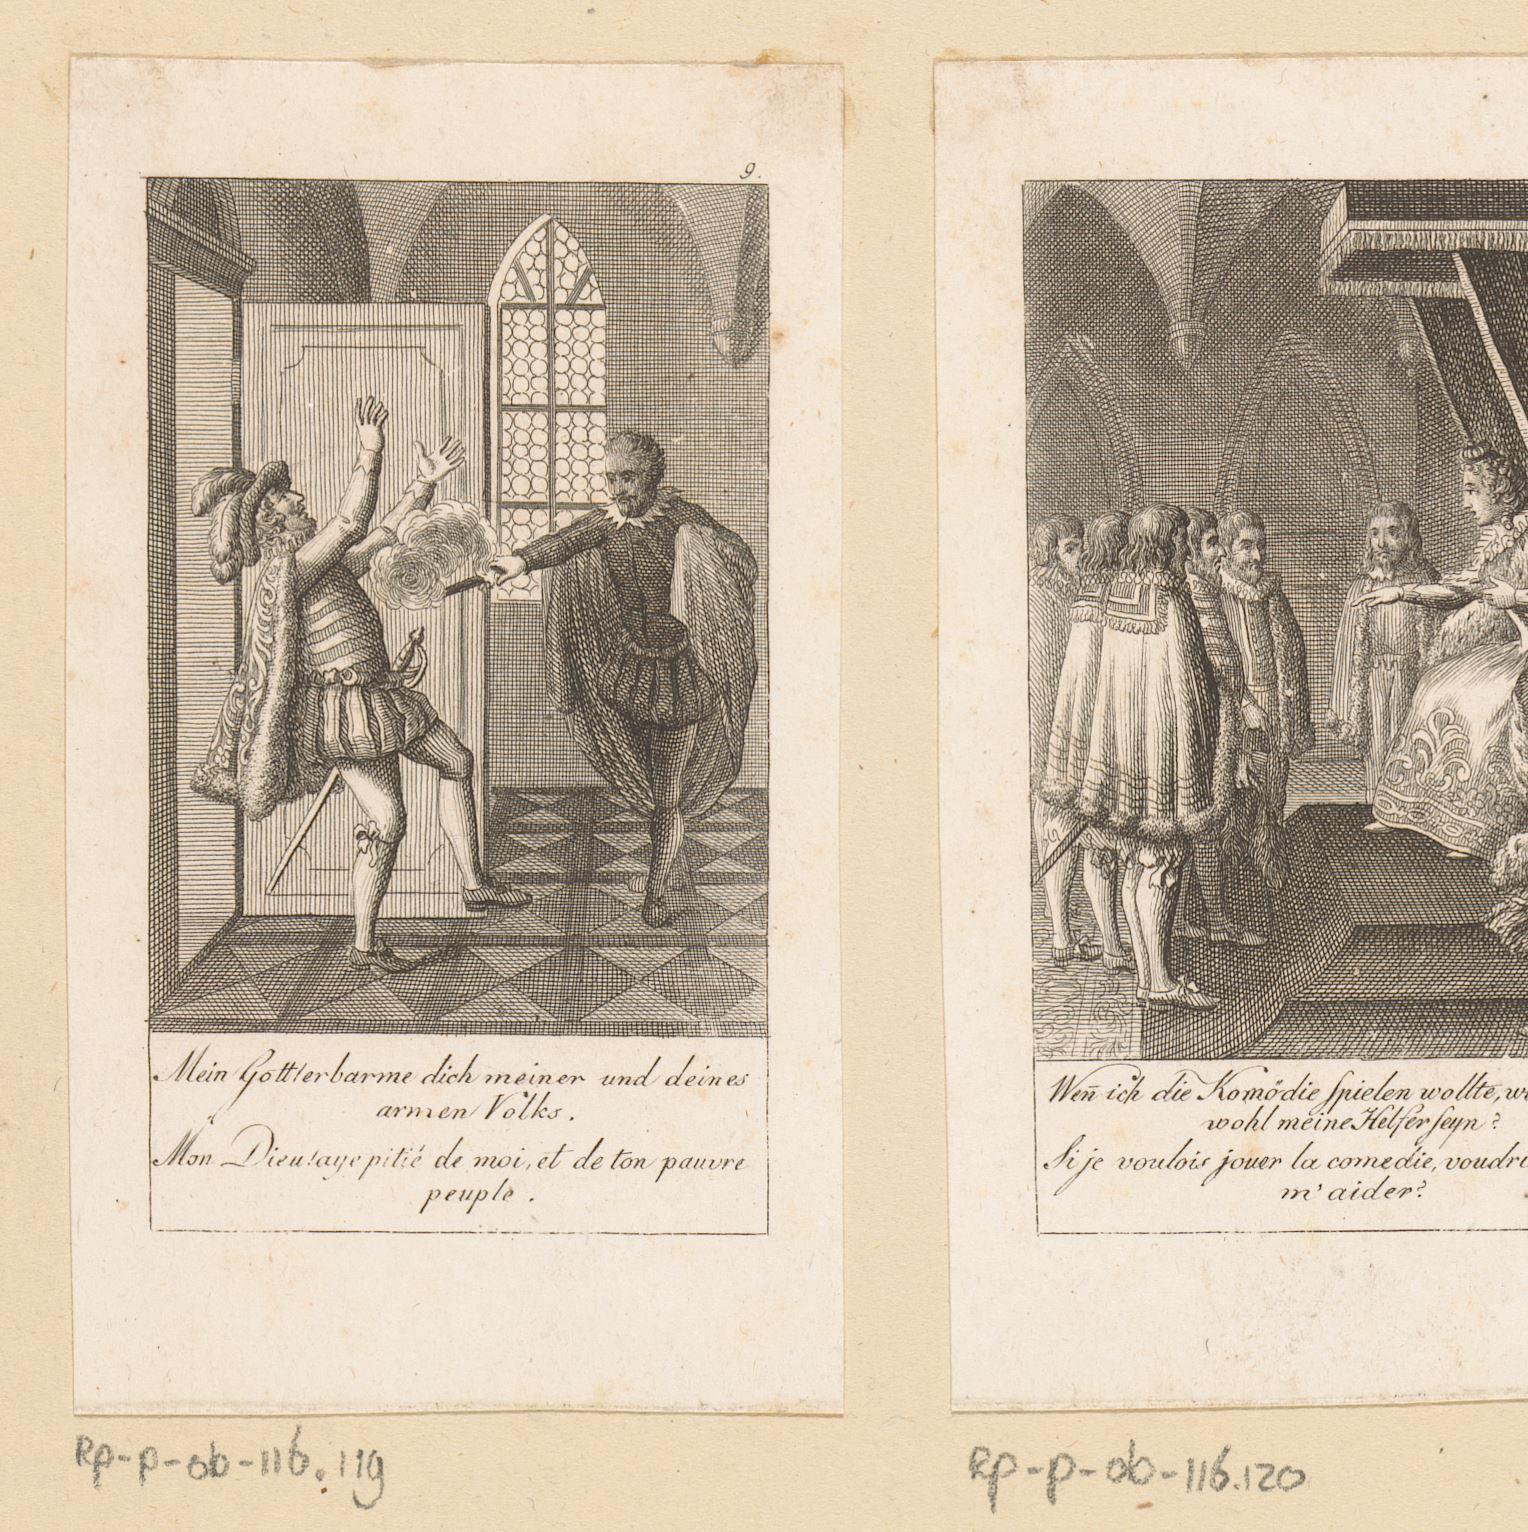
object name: print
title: Voorstelling uit de geschiedenis van de Nederlandse stadhouders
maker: christian gottlieb geyser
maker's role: print maker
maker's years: 1742-1803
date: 1796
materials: paper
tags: william i (prince of orange), history, violent death by firearms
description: Prent gebruikt voor: Geschichte der Statthalterschaft der Niederlande. Gotha: s.n., 1796.